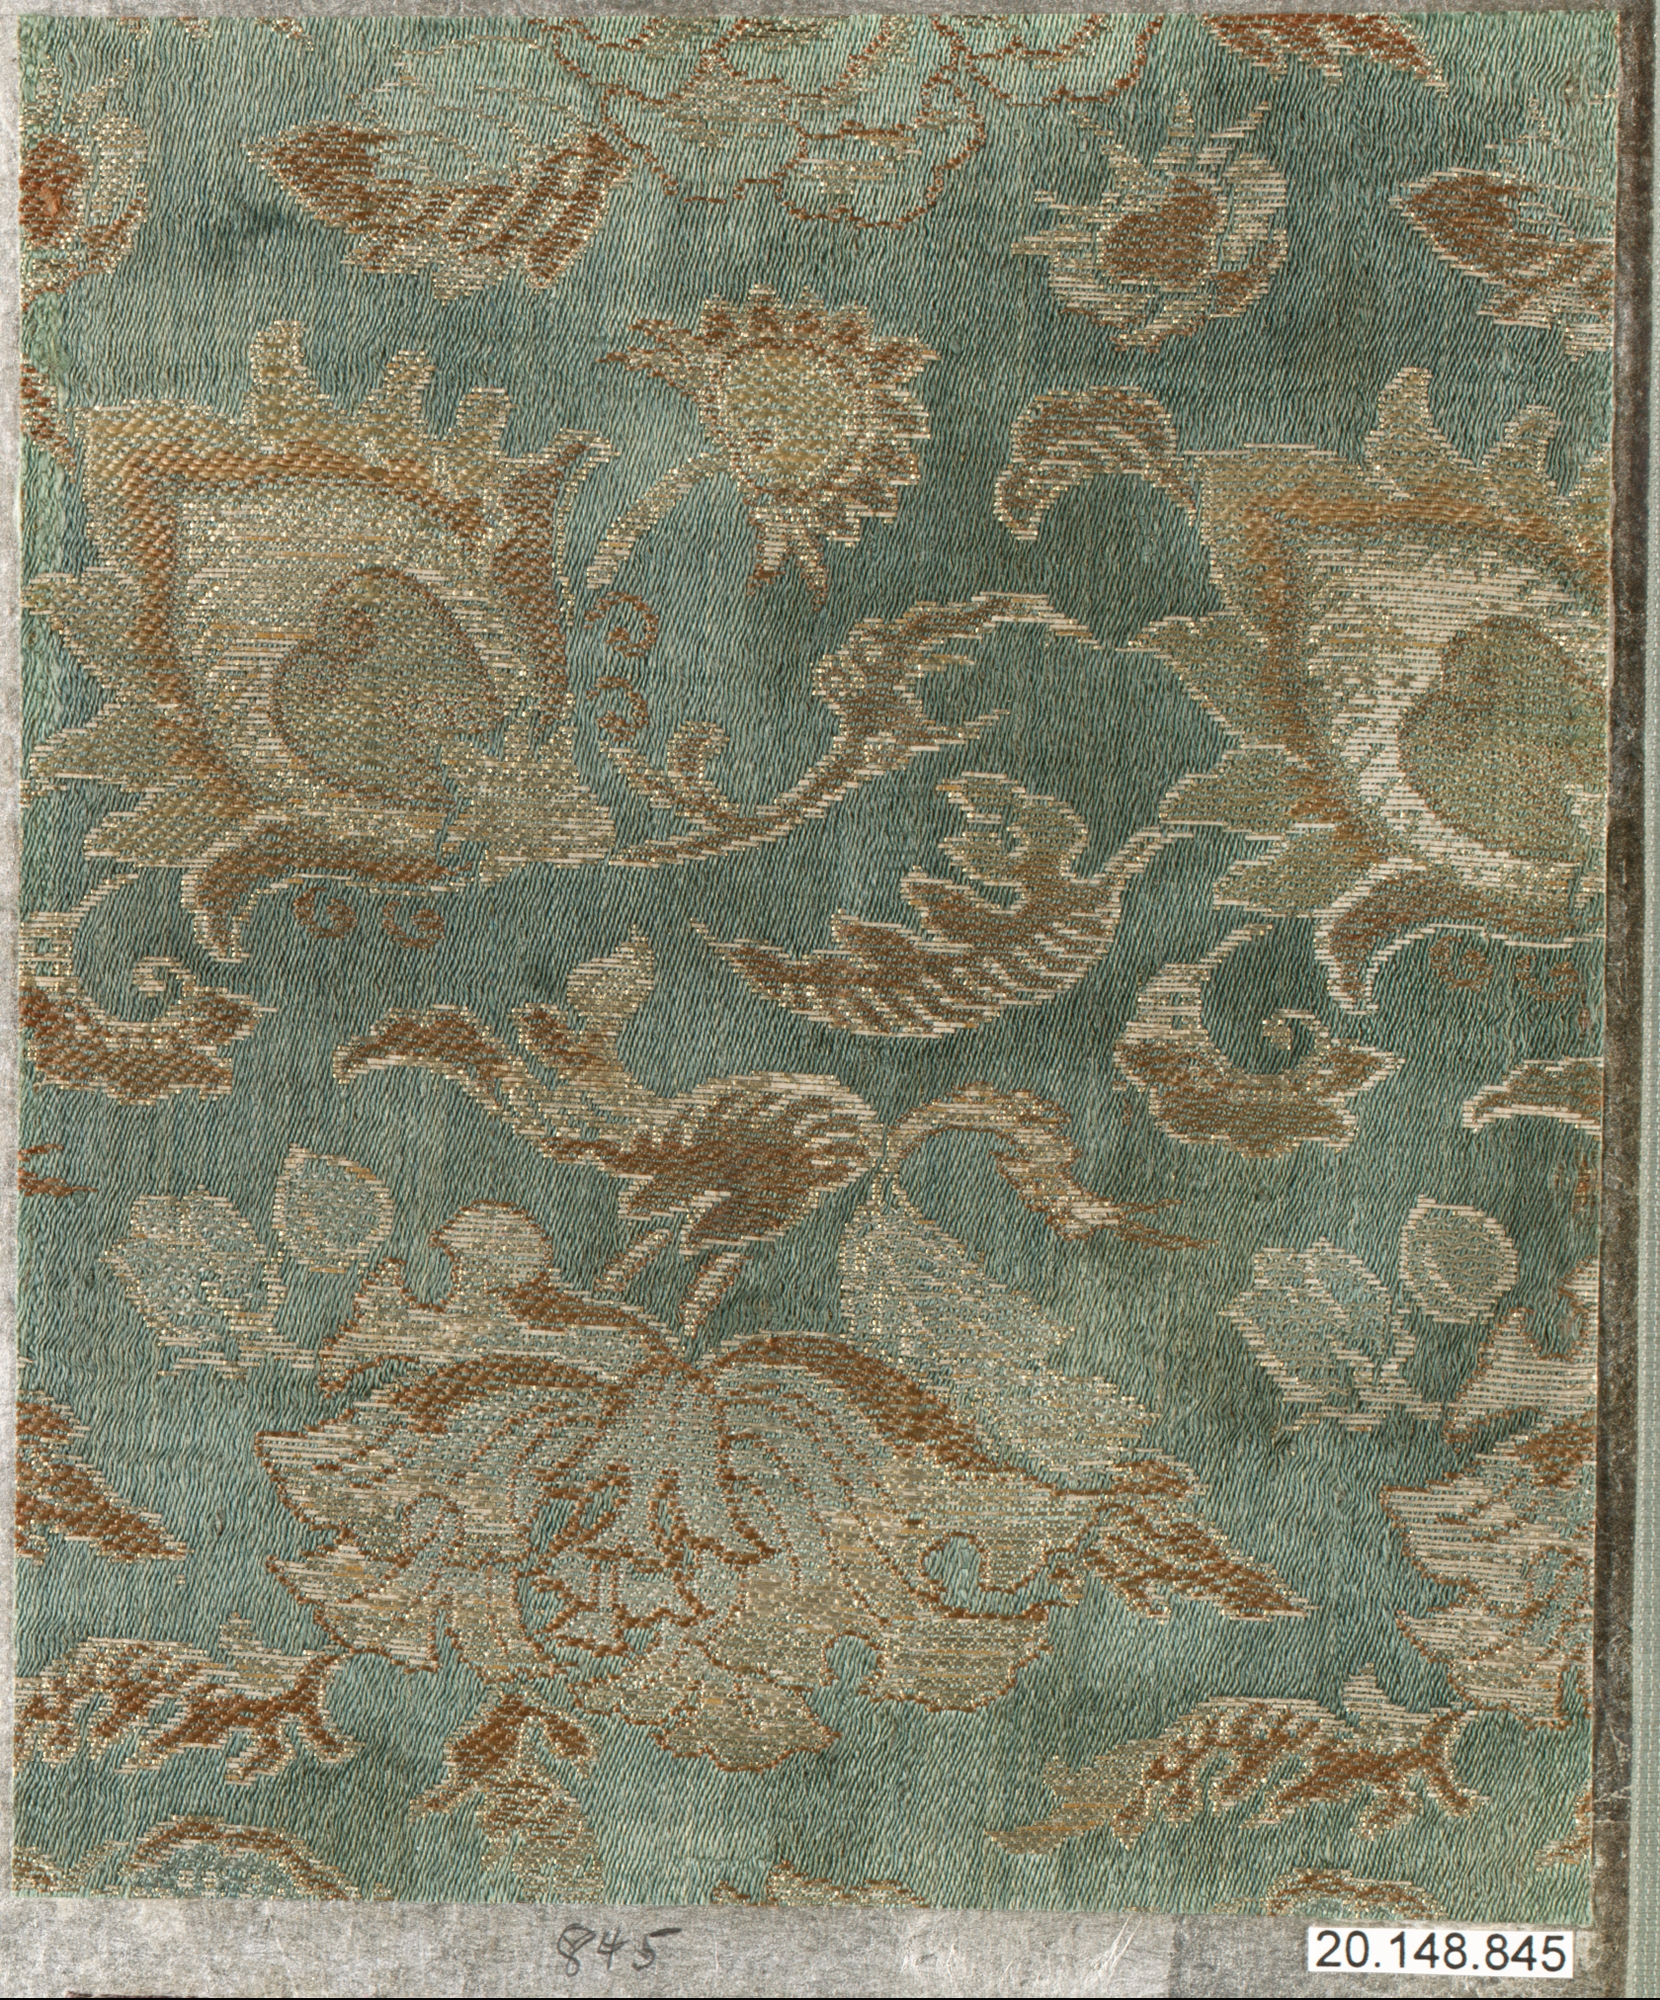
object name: piece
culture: japanese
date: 1601-1700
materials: silk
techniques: compound weave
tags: flowers